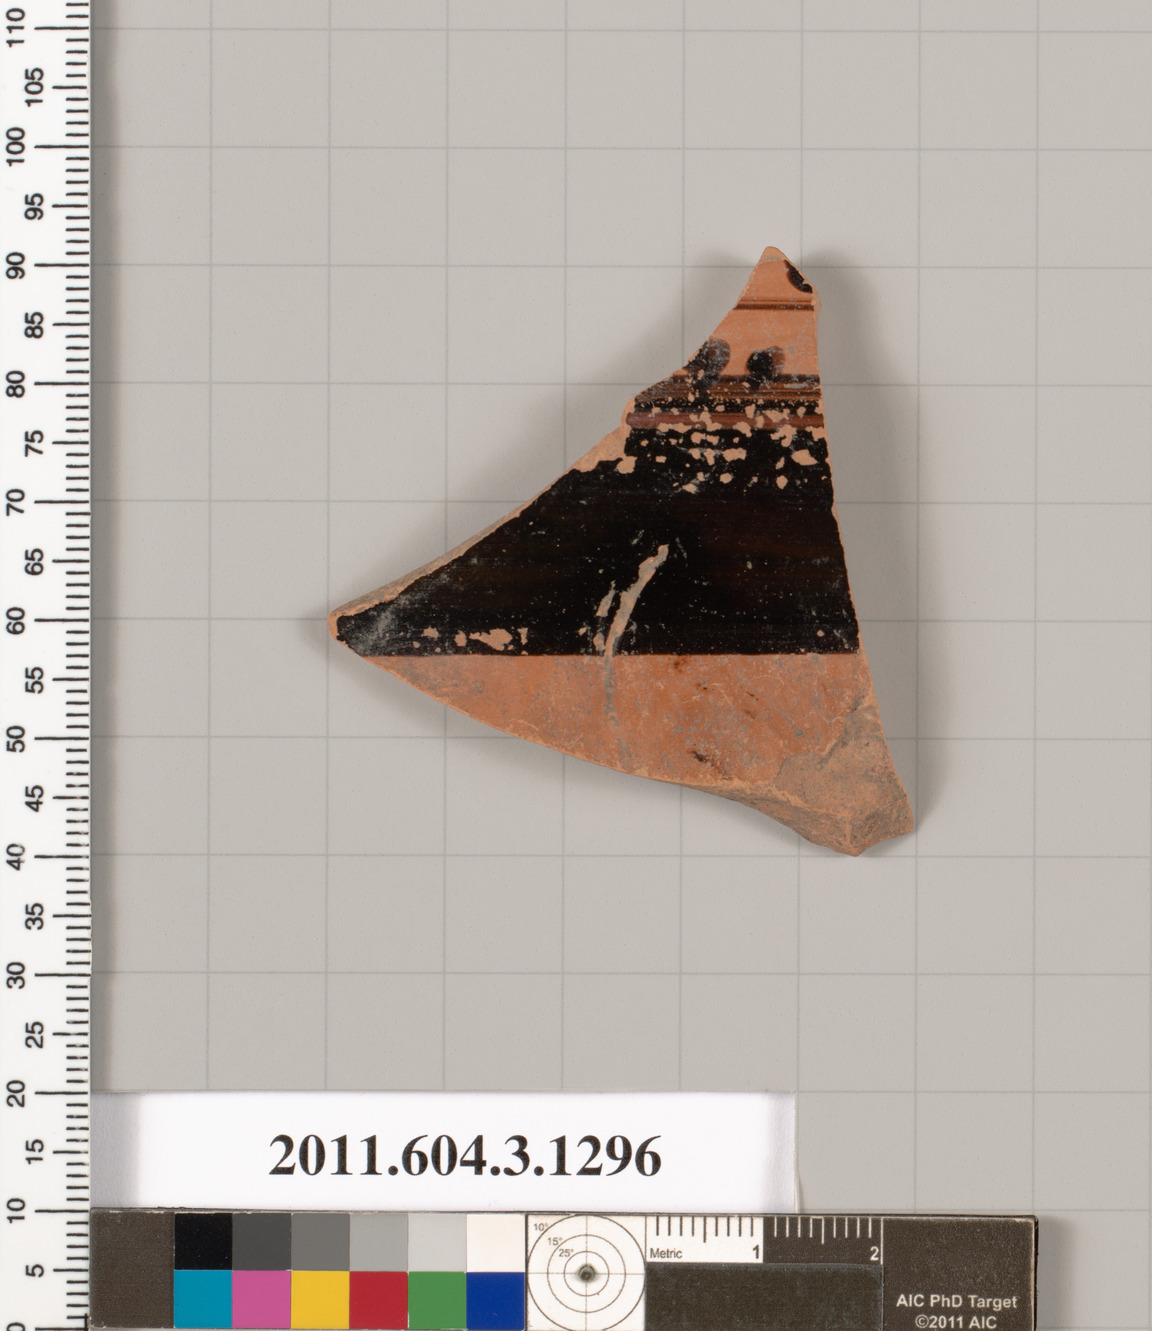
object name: skyphos fragment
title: Terracotta fragment of a skyphos (deep drinking cup)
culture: greek, attic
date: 500 BCE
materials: terracotta